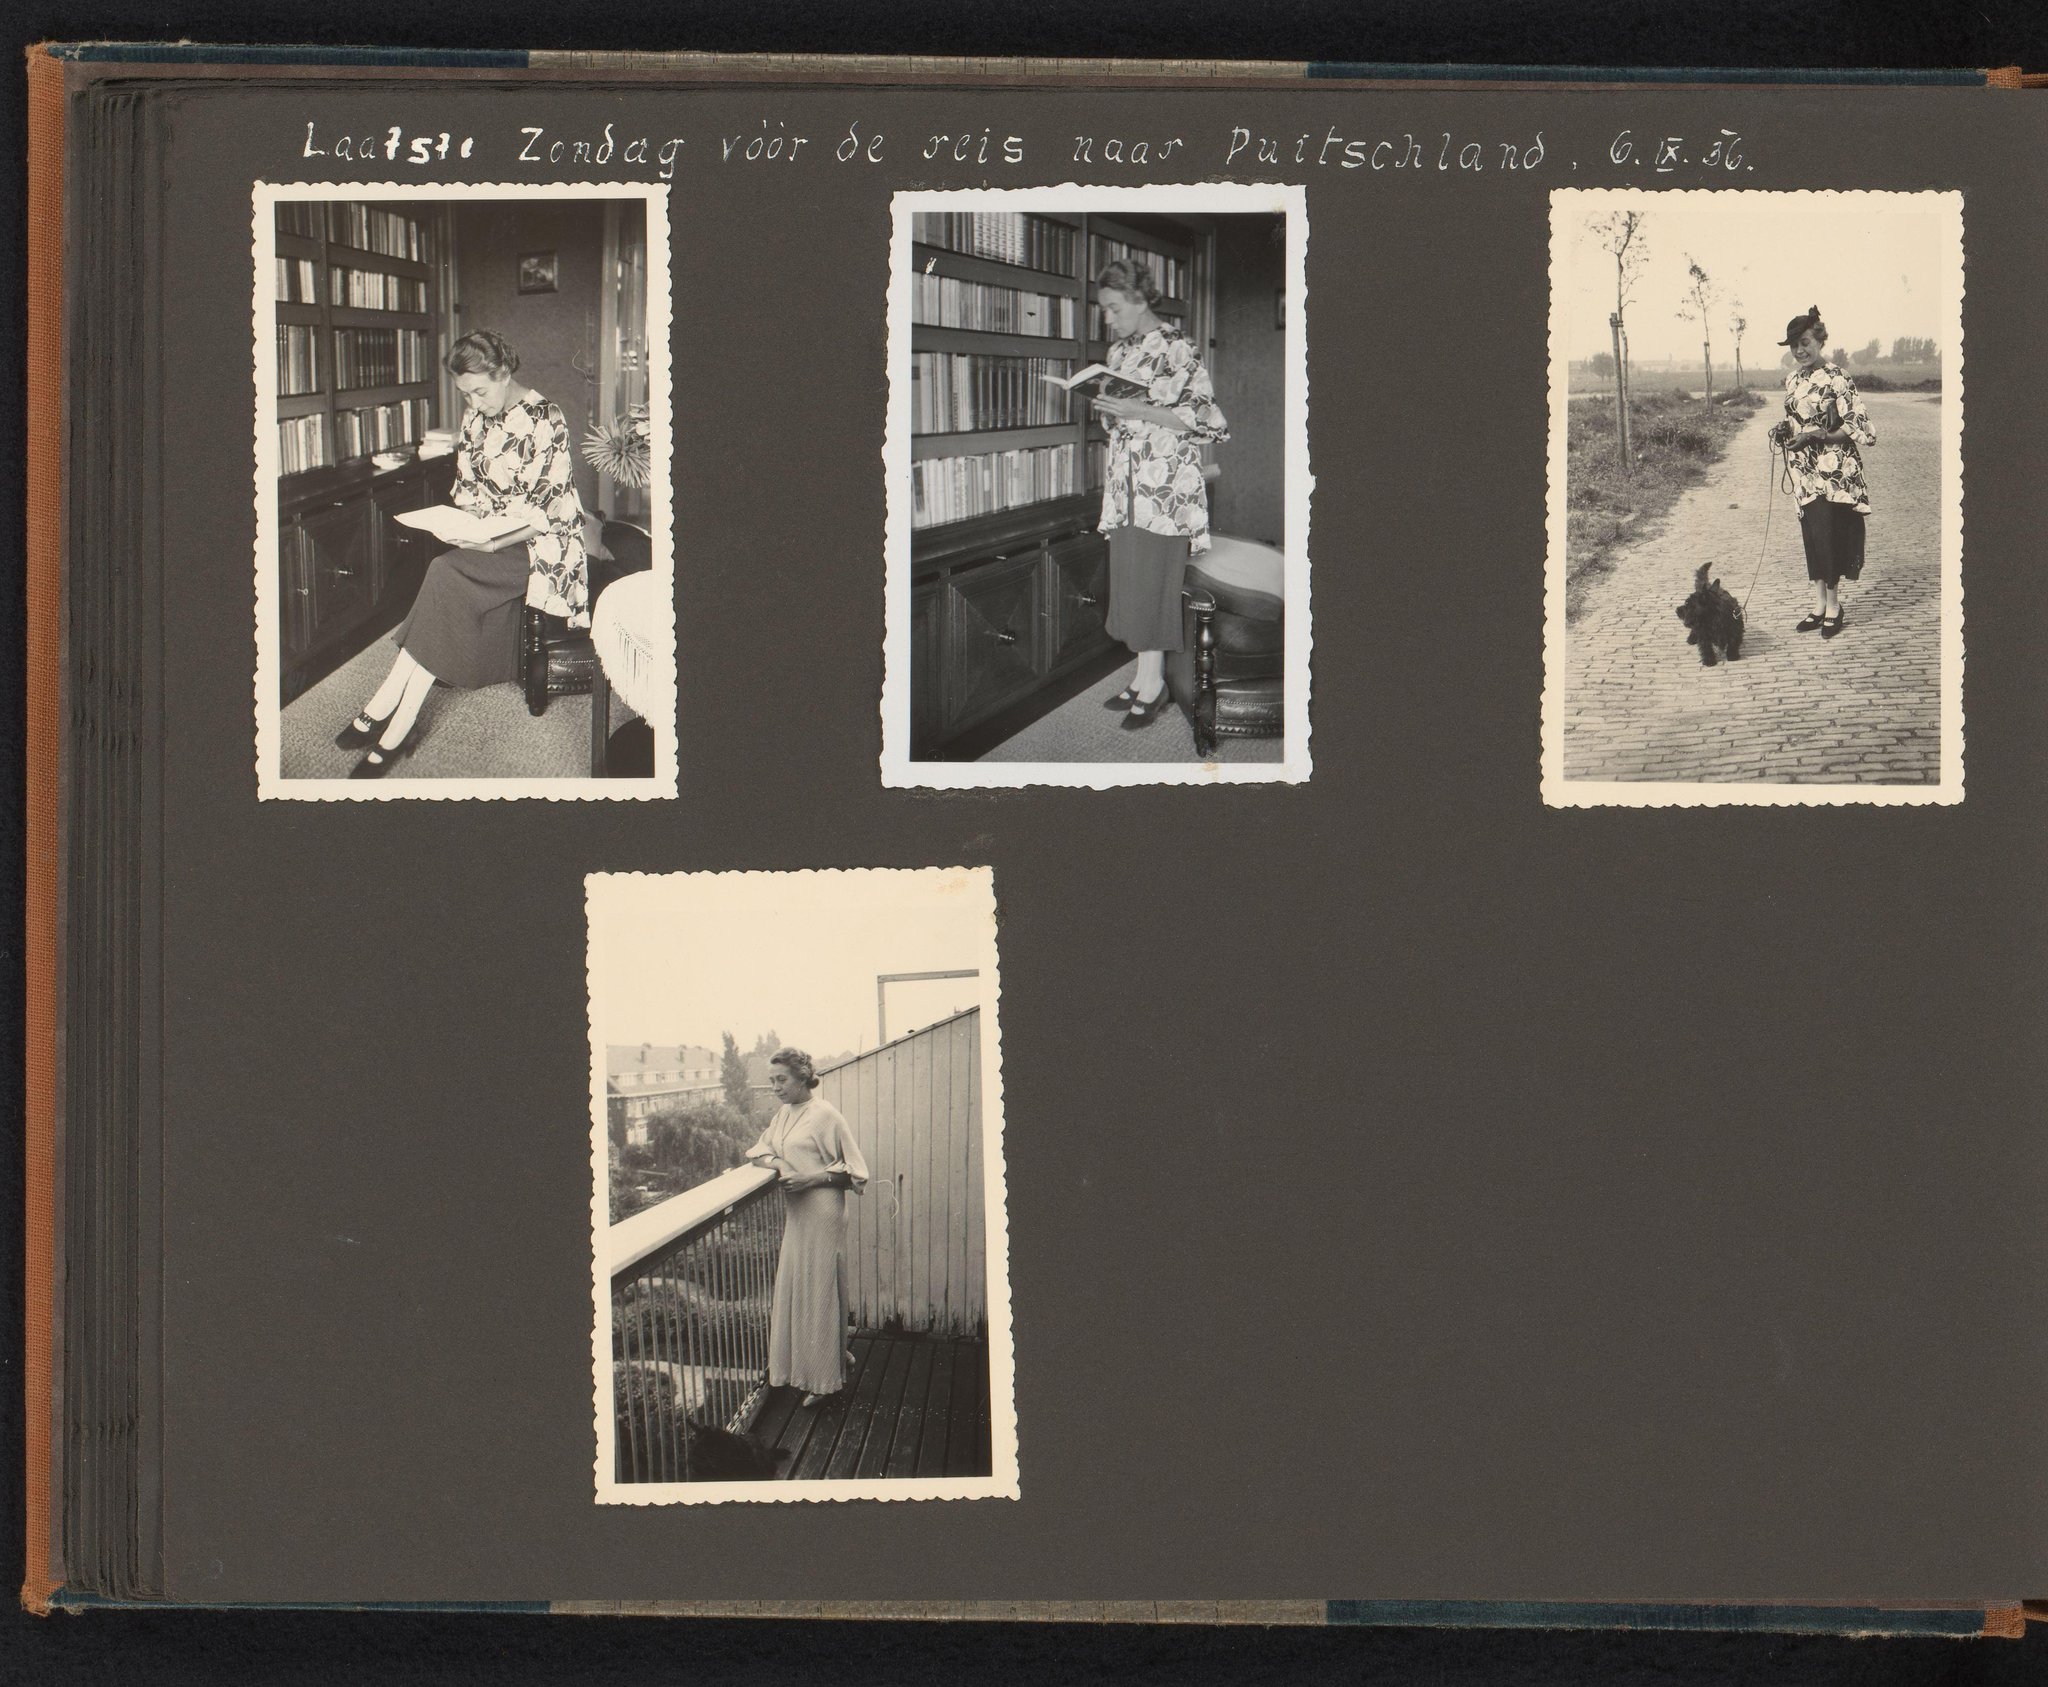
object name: album leaf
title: Berti Hoppe thuis en wandelend met de hond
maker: herman besselaar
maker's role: taalkundige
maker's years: 1904-1994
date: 1936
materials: cardboard, paper, photographic support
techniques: gelatin silver print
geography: rotterdam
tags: berti hoppe, historical persons, walking the dog, rotterdam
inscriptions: date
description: Vier foto's van Berti Hoppe in en rond het huis. Deze pagina maakt deel uit van een album.